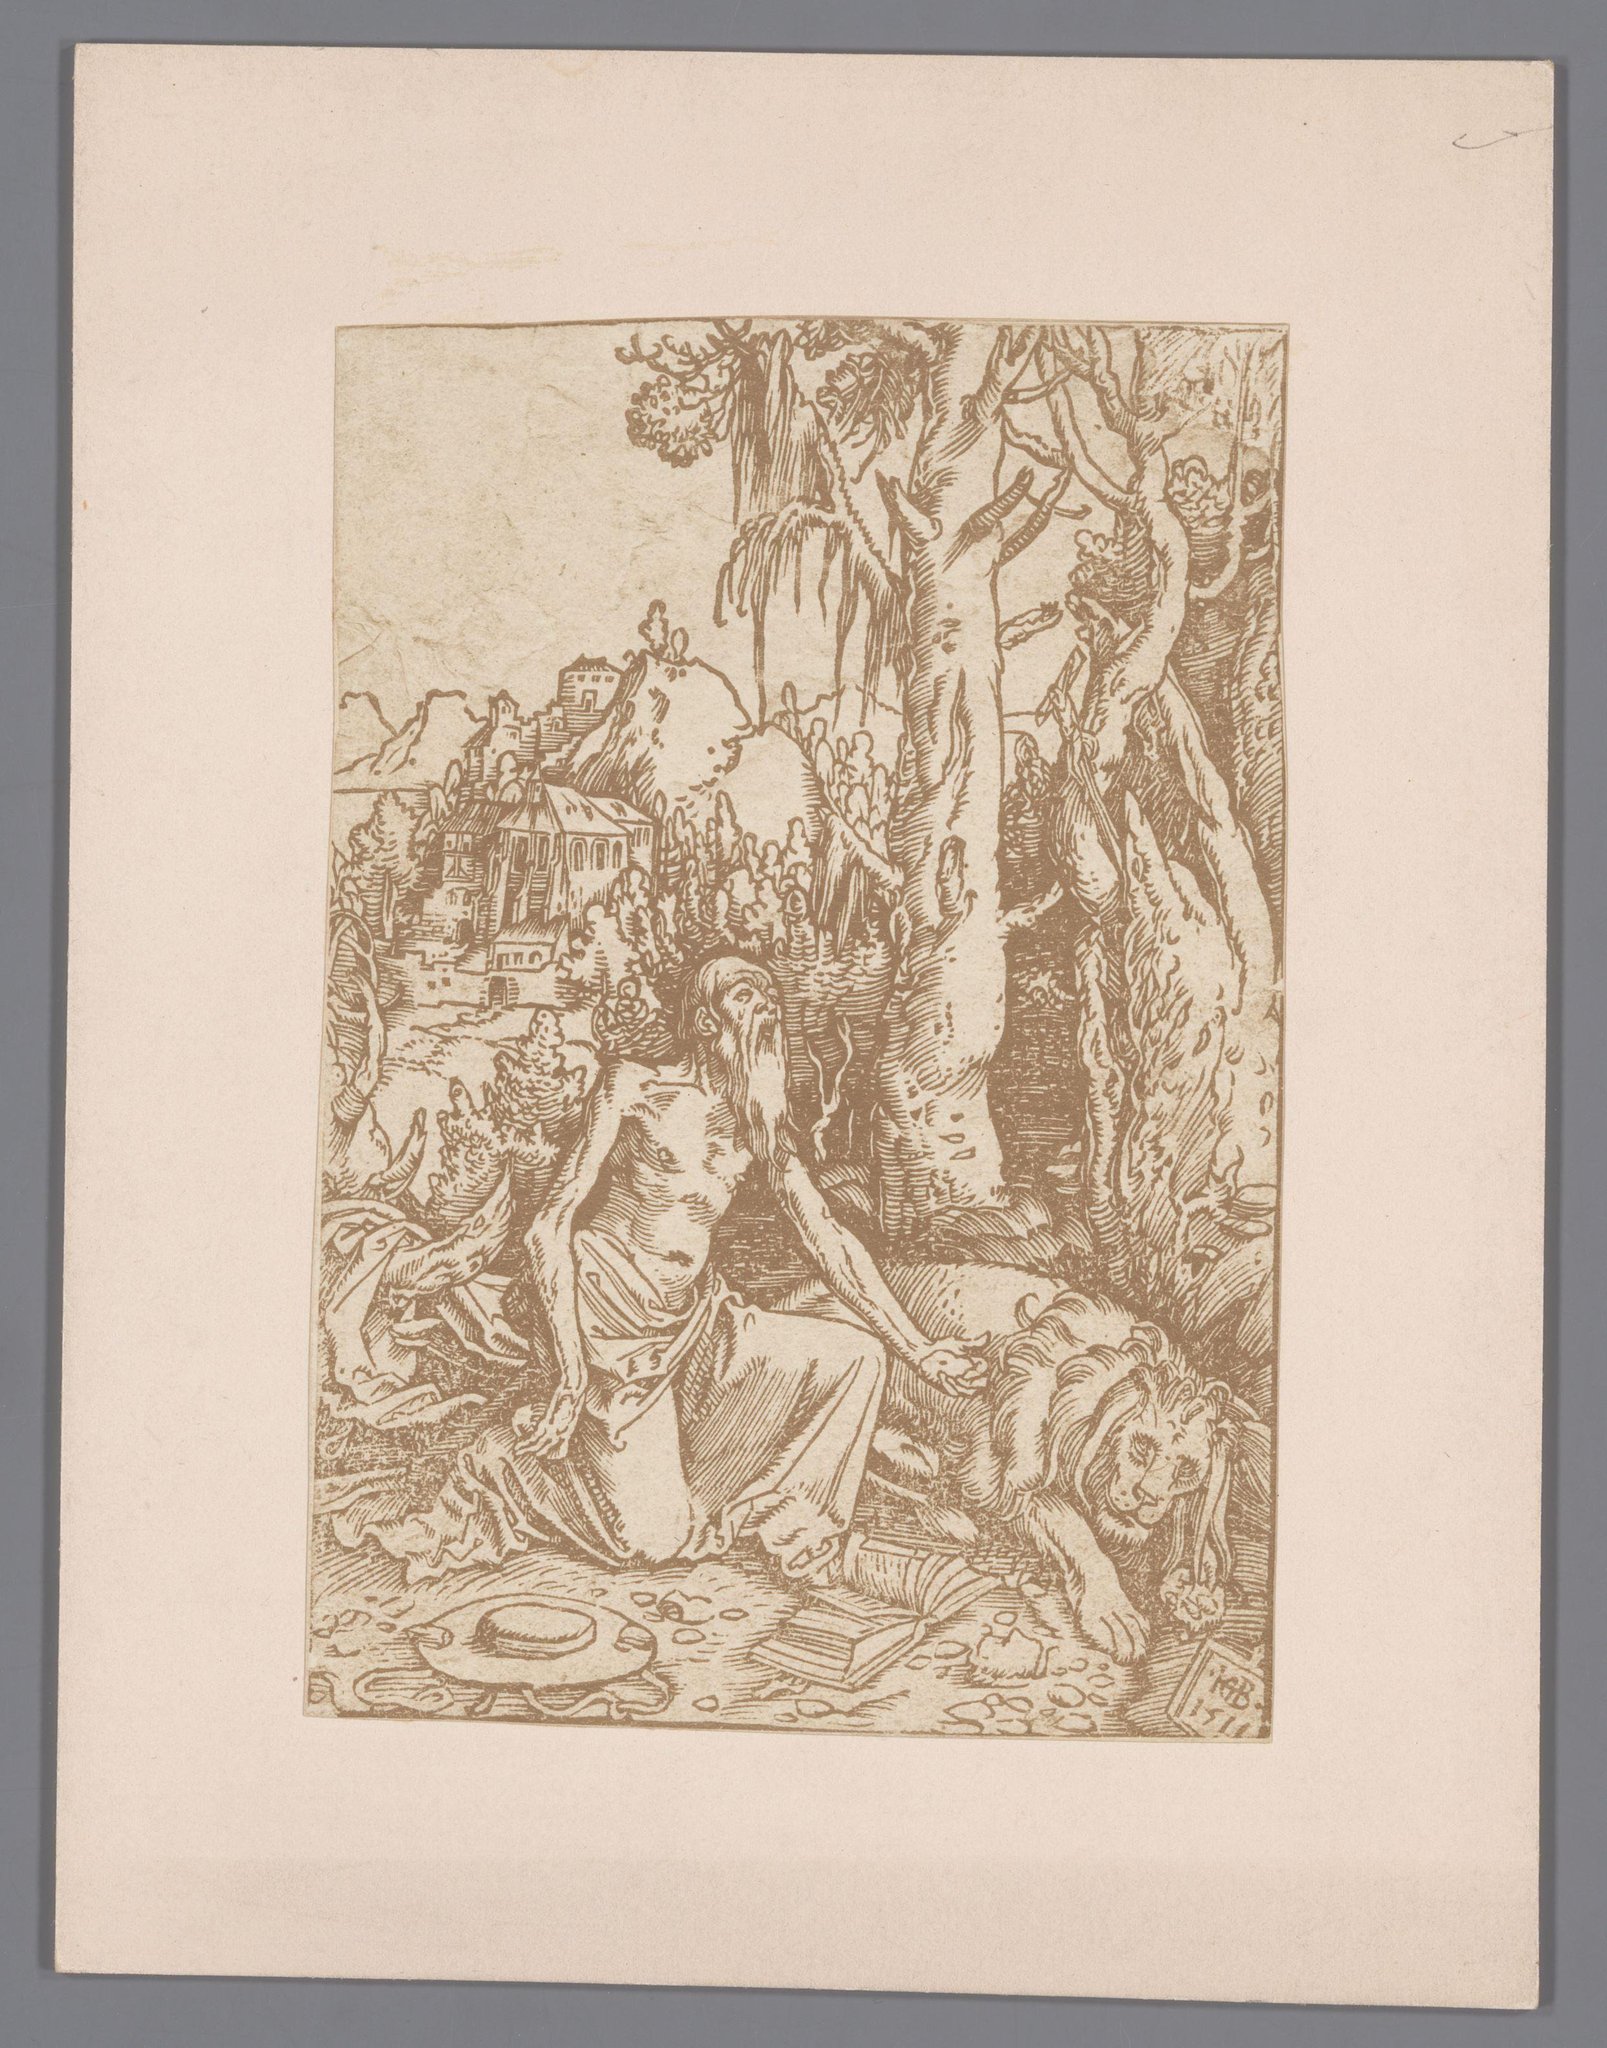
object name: reproduction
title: Fotoreproductie van Heilige Hieronymus als boeteling in de woestijn door Hans Baldung Grien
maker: Anonymous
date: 1910-1940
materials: paper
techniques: gelatin silver print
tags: print, e.g.: engraving, etching, lithograph, st. jerome as penitent in the desert, half naked, kneeling before a crucifix and holding a stone in his hand to beat his breast; a skull (and other 'vanitas' symbols), sometimes a scorpion and a snake beside him, germany